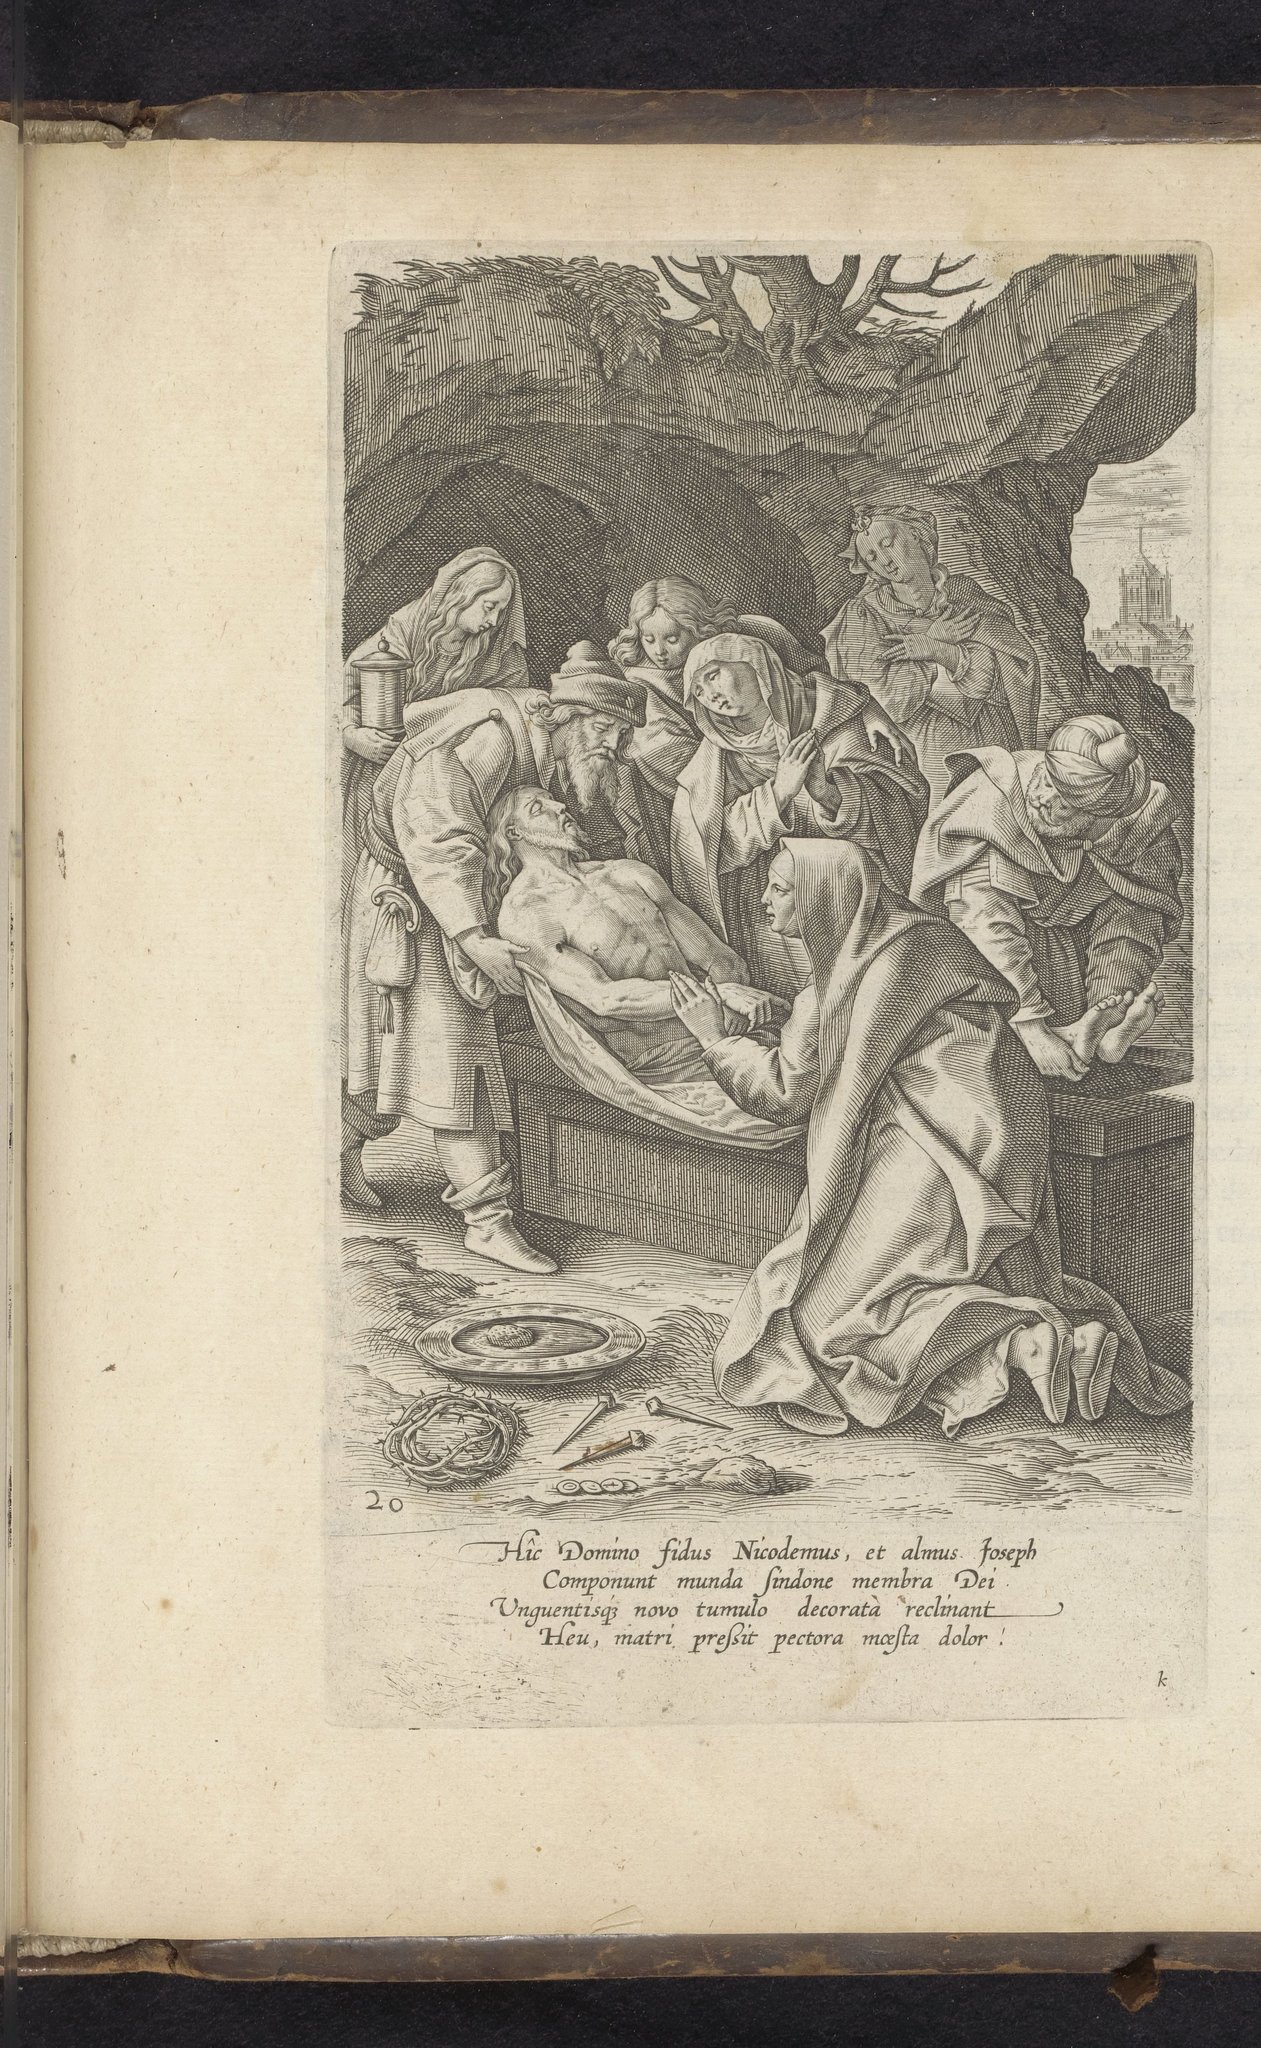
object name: print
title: Passie van Christus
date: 1585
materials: paper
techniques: engraving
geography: amsterdam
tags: christ's entombment (possibly by angels)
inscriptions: number: ‘142’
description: Christus wordt door Josef van Arimatea en Nikodemus in het rotsgraf gelegd. Rond het graf de treurende heilige vrouwen. Op de voorgrond de passiewerktuigen. Onder de voorstelling een vierregelig vers in het Latijn. Rechtsonder de letter: k. Deze prent maakt deel uit van een album.